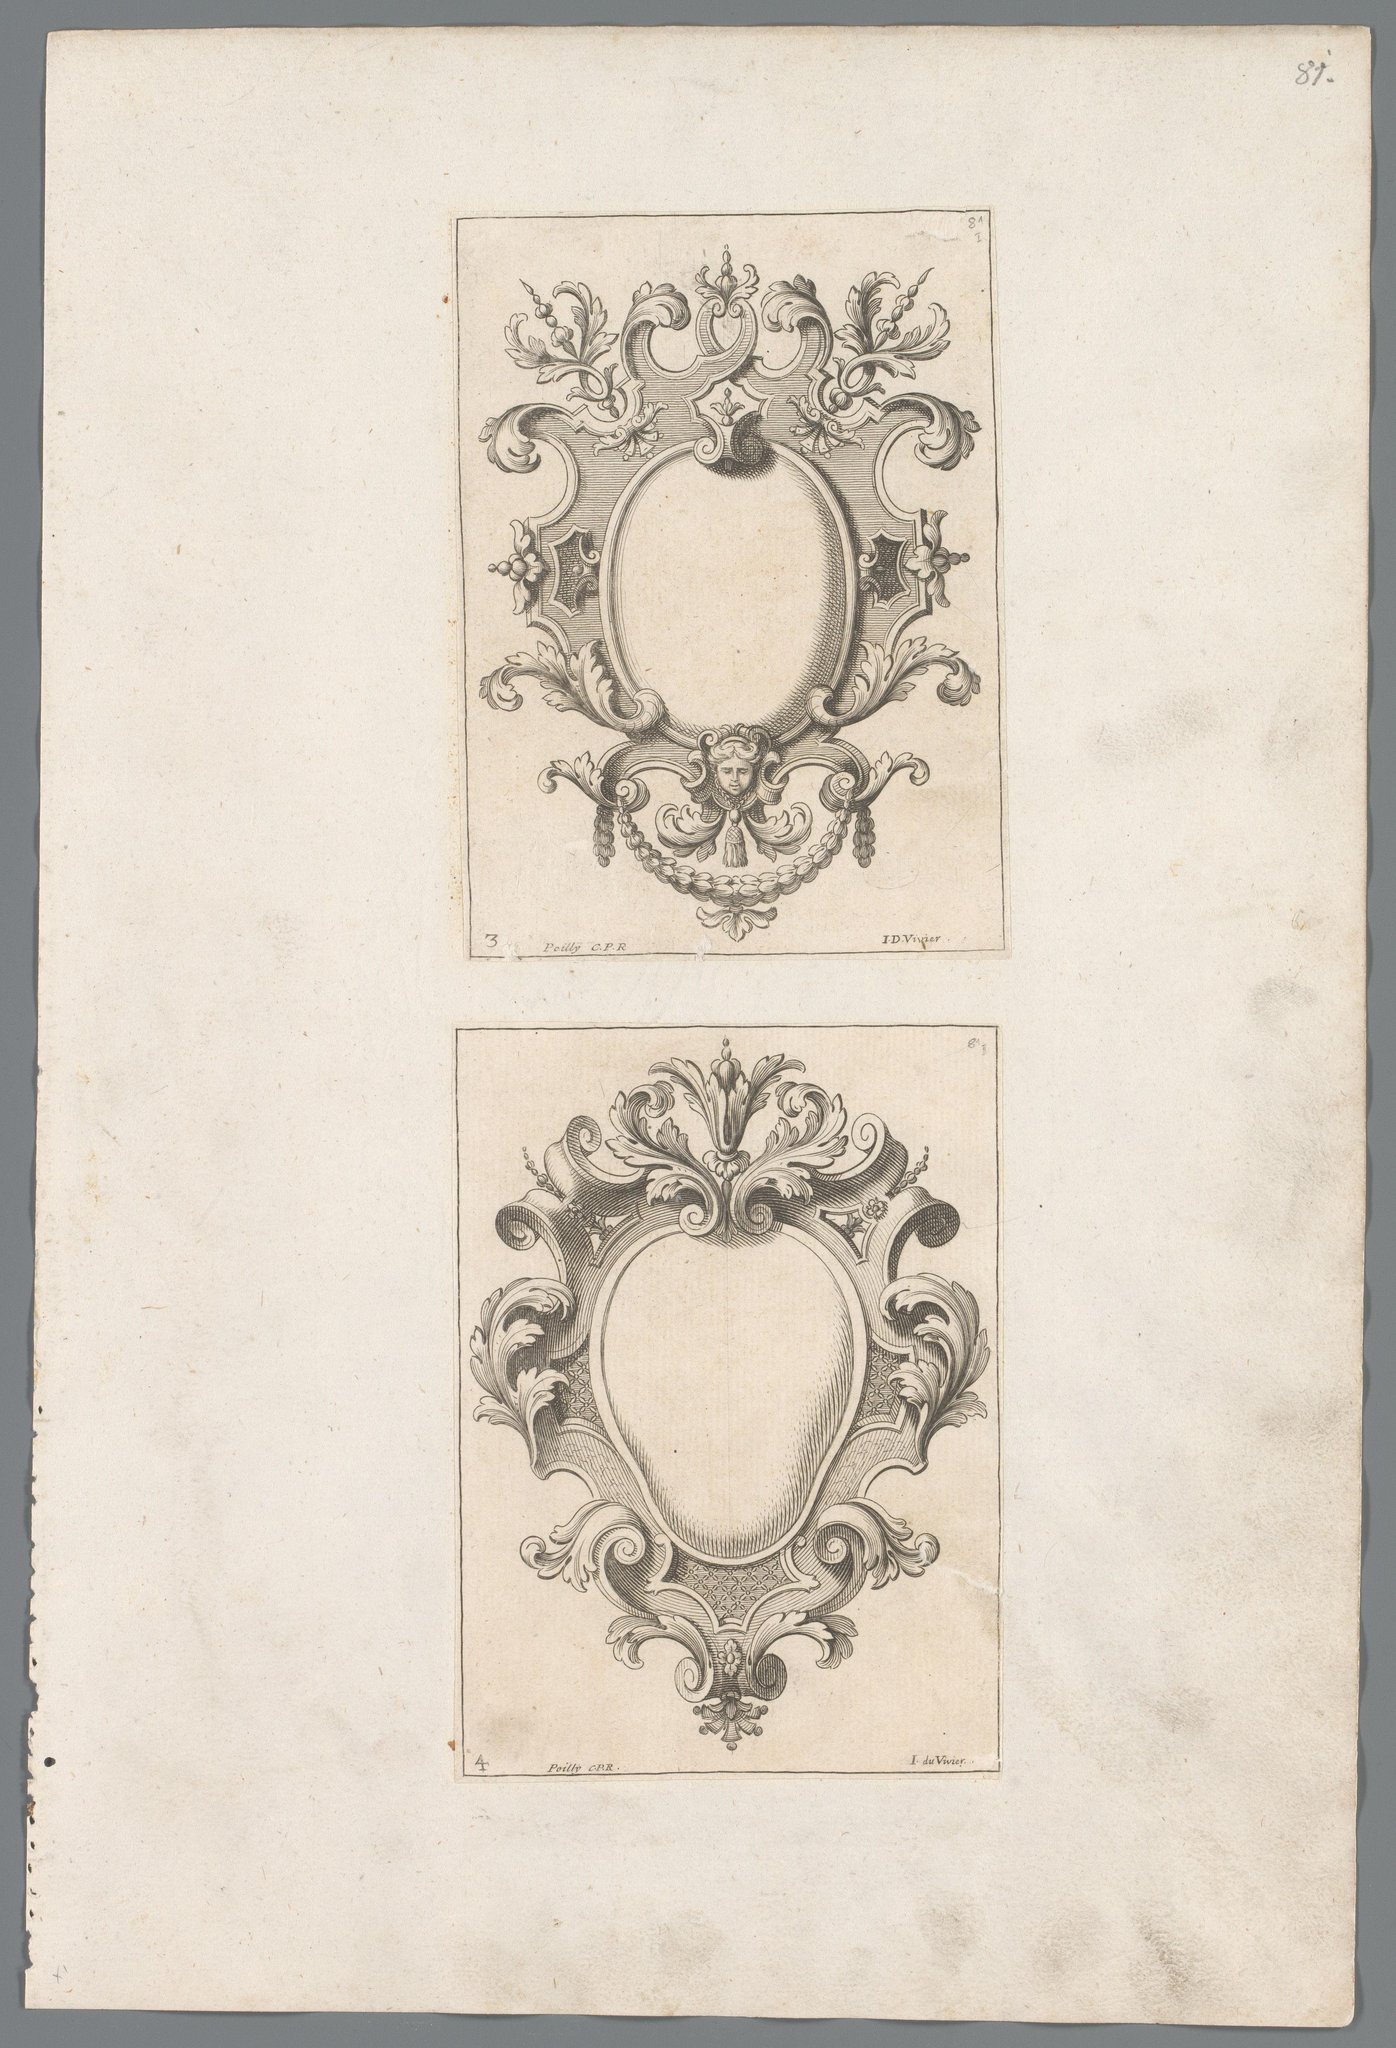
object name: ornament print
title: Nouveau livre de cartouche, pour ornemens des armes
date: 1712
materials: paper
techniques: engraving, etching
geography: paris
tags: ornament ~ cartouche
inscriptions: collector's mark: Lugt 2228, collector's mark: Lugt 2760